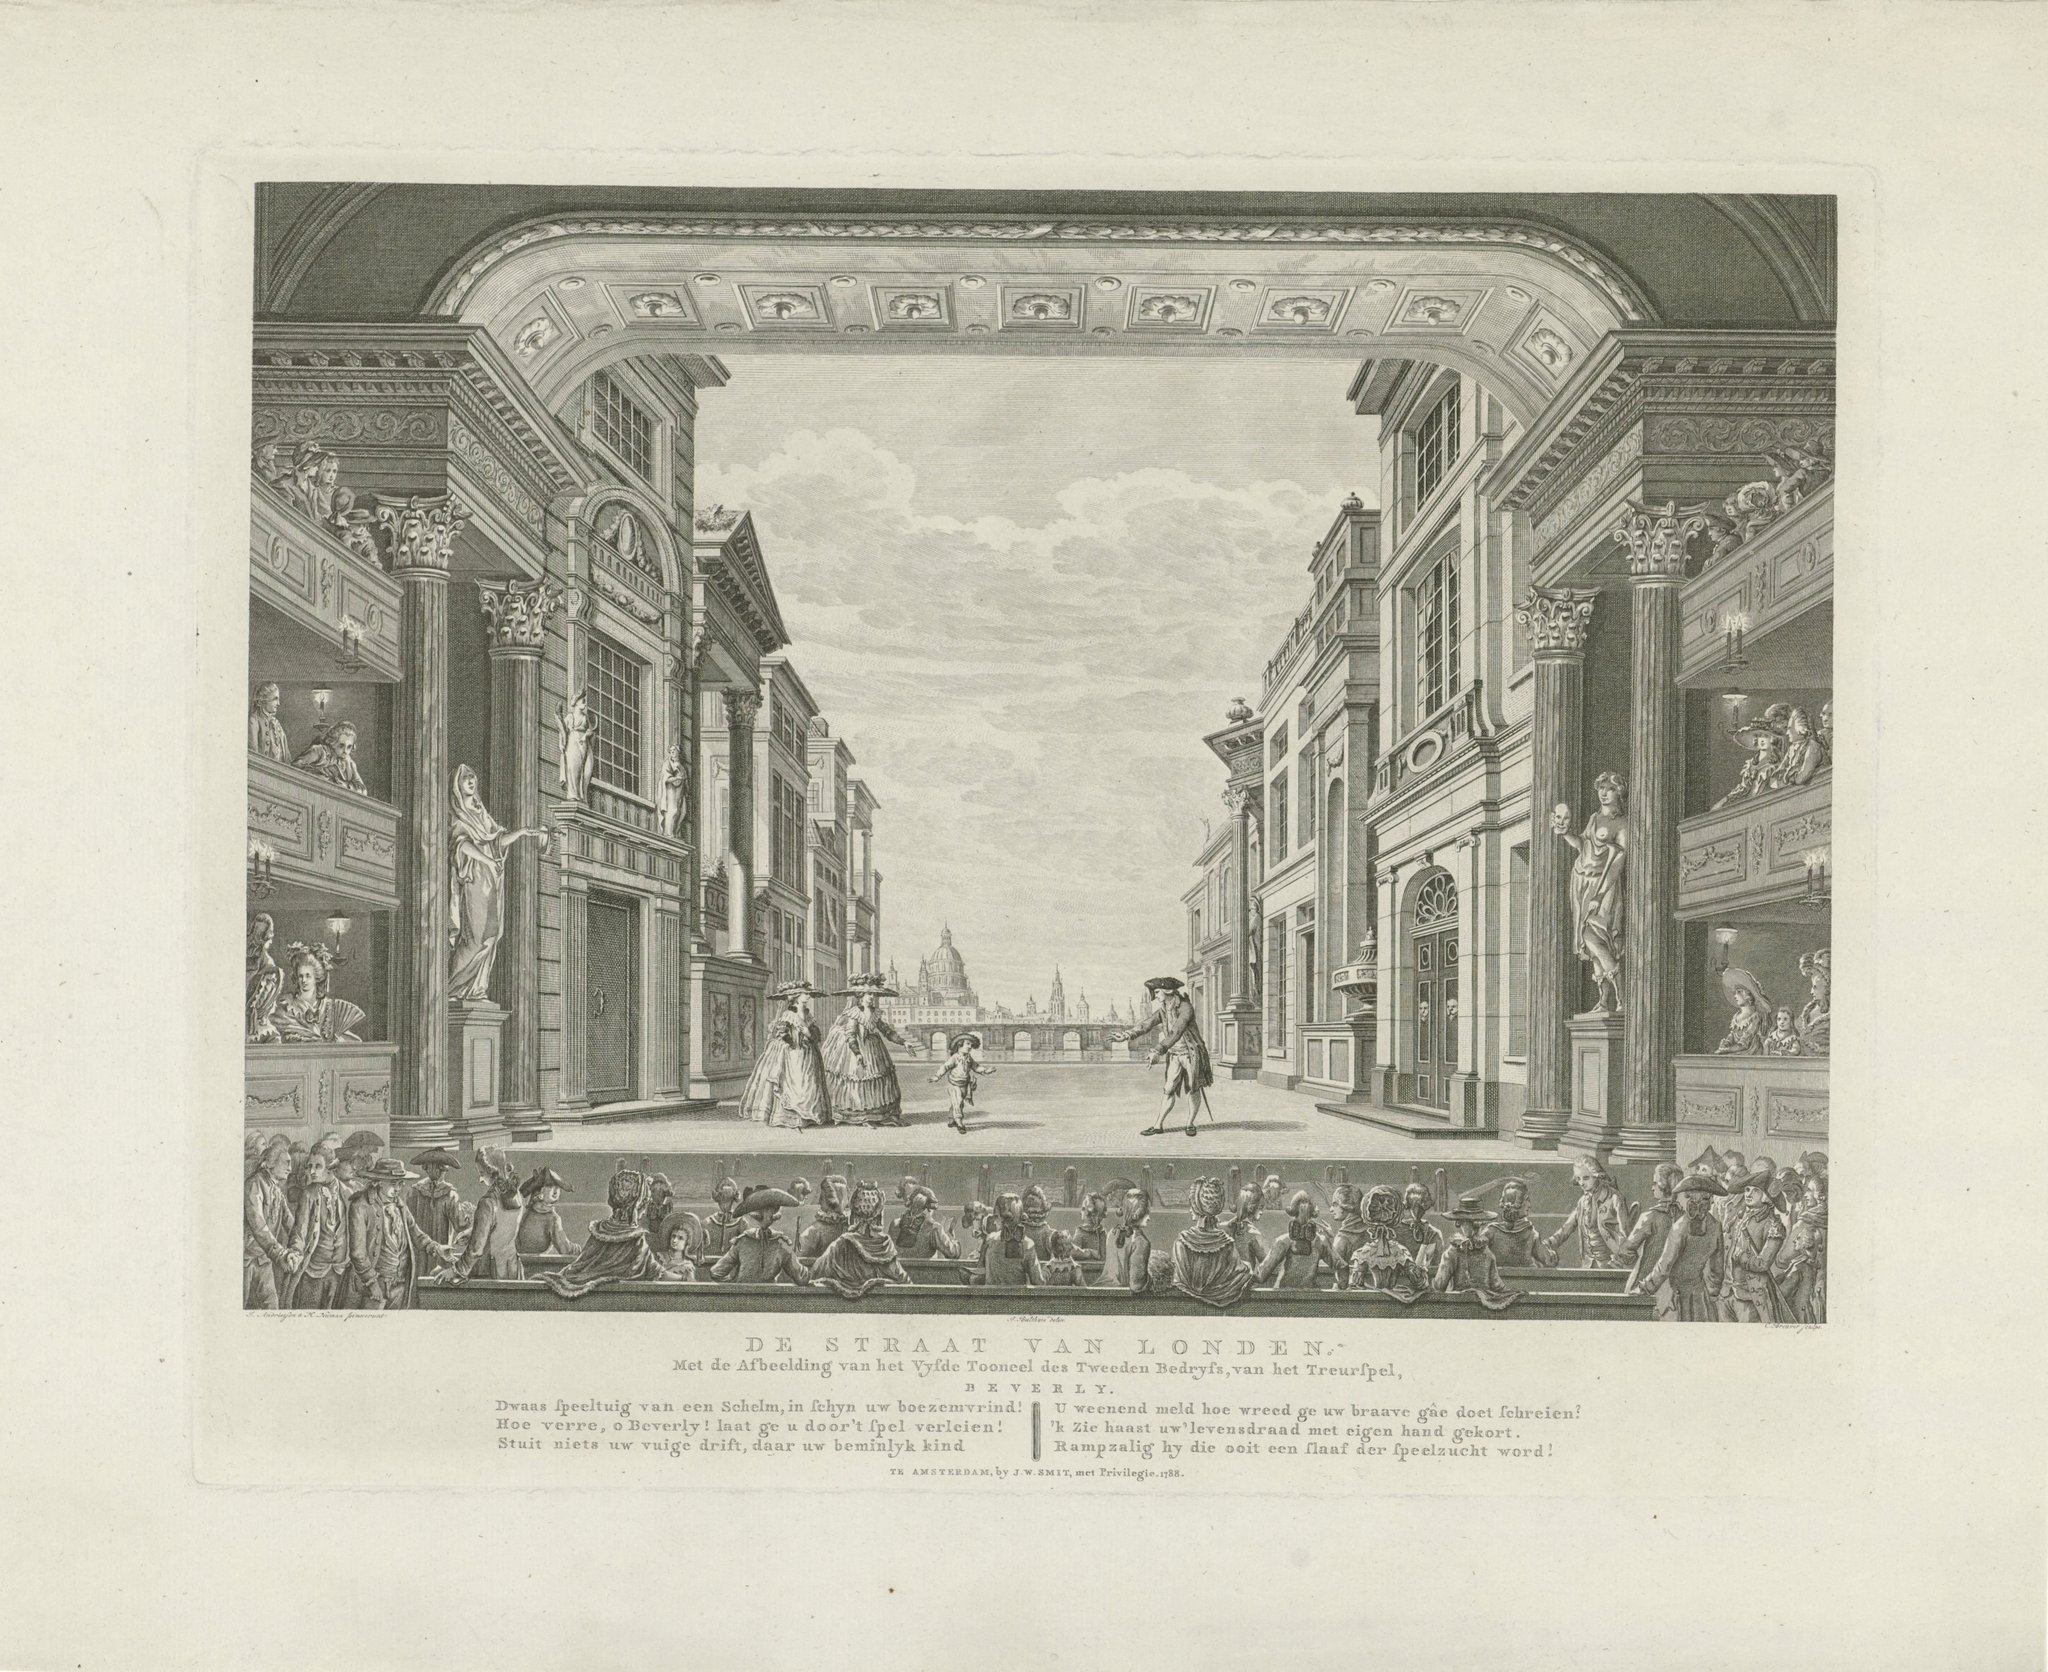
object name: print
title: Toneeldecors van de nieuwe Amsterdamse Schouwburg, 1787-1794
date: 1788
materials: paper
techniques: engraving, etching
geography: amsterdam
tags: theatre, theatrical performance, stage design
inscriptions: collector's mark: Lugt 2228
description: Toneelvoorstelling in de nieuwe Amsterdamse Schouwburg met het coulissendecor De Straat van Londen, met scène uit Beverly. Het decor gedrukt van een aparte plaat binnen een vernieuwde passe-partout met de zaal, zijloges, pilaren met standbeelden en de façade van het toneel. In het onderschrift een zesregelig vers. Onderdeel van de serie van veertien toneeldecors van de nieuwe Amsterdamse Schouwburg, 1787-1794.